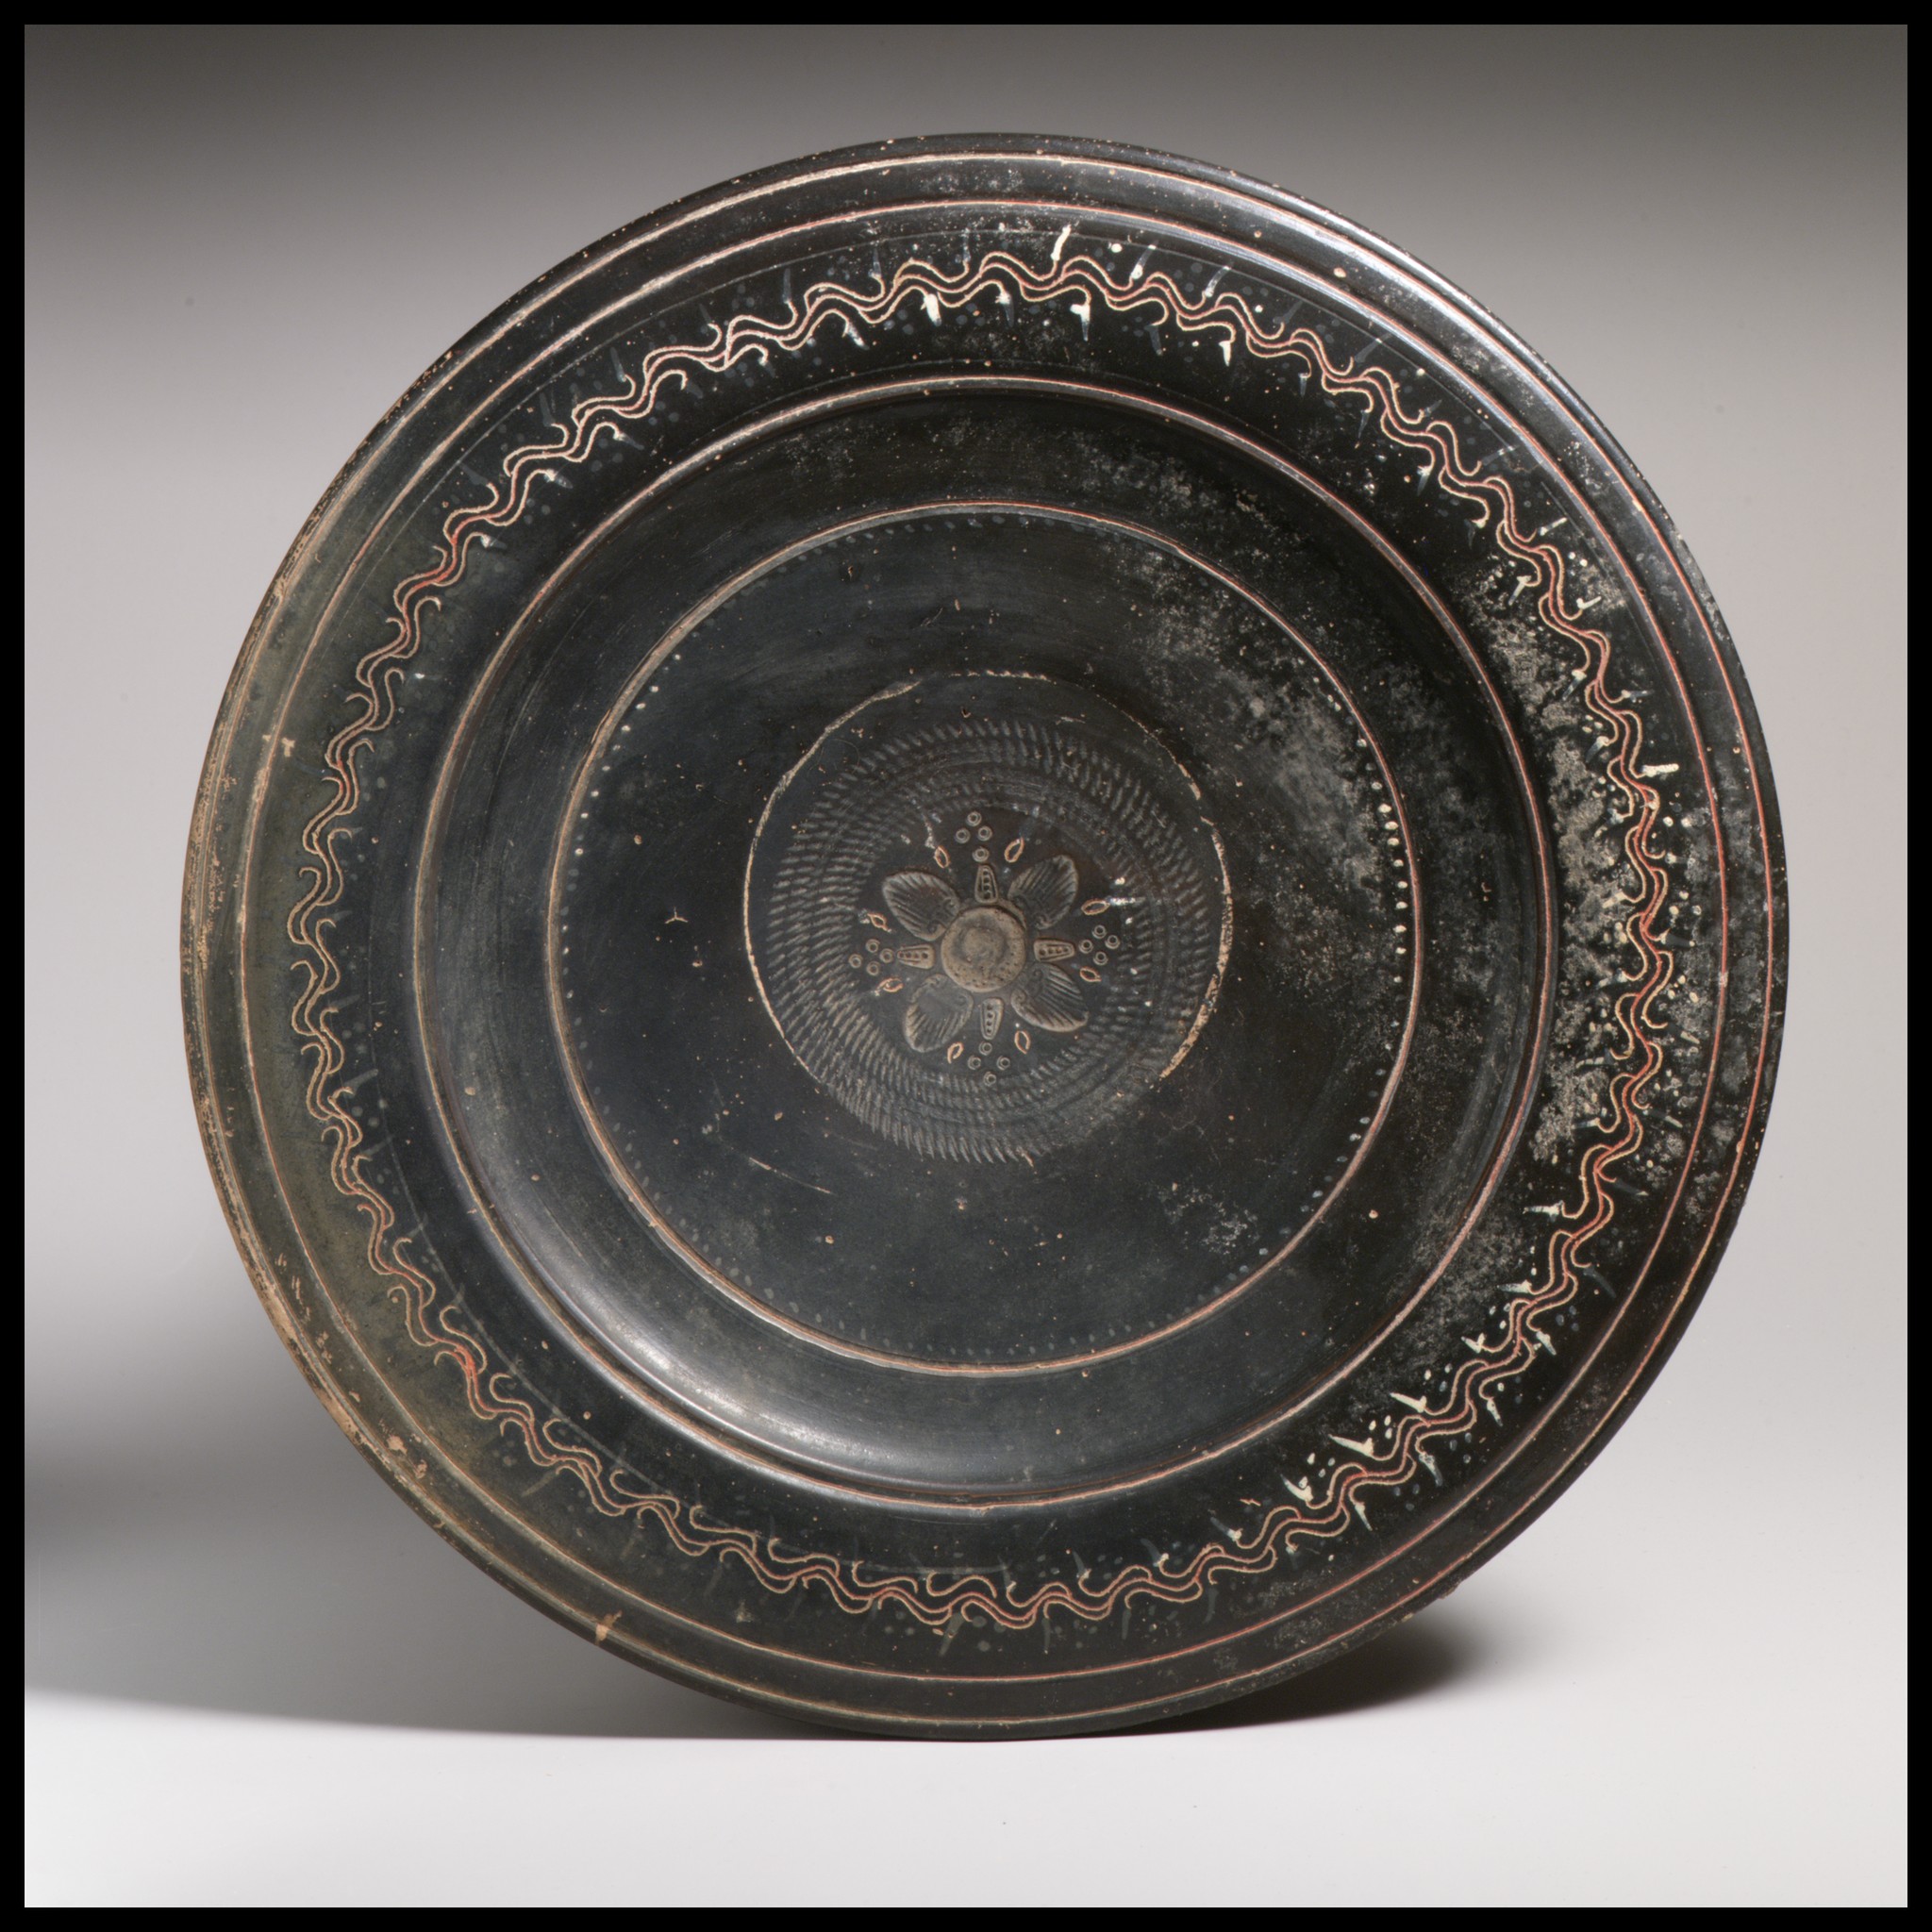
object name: dish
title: Terracotta dish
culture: greek, south italian, campanian, teano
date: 330-300 BCE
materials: terracotta